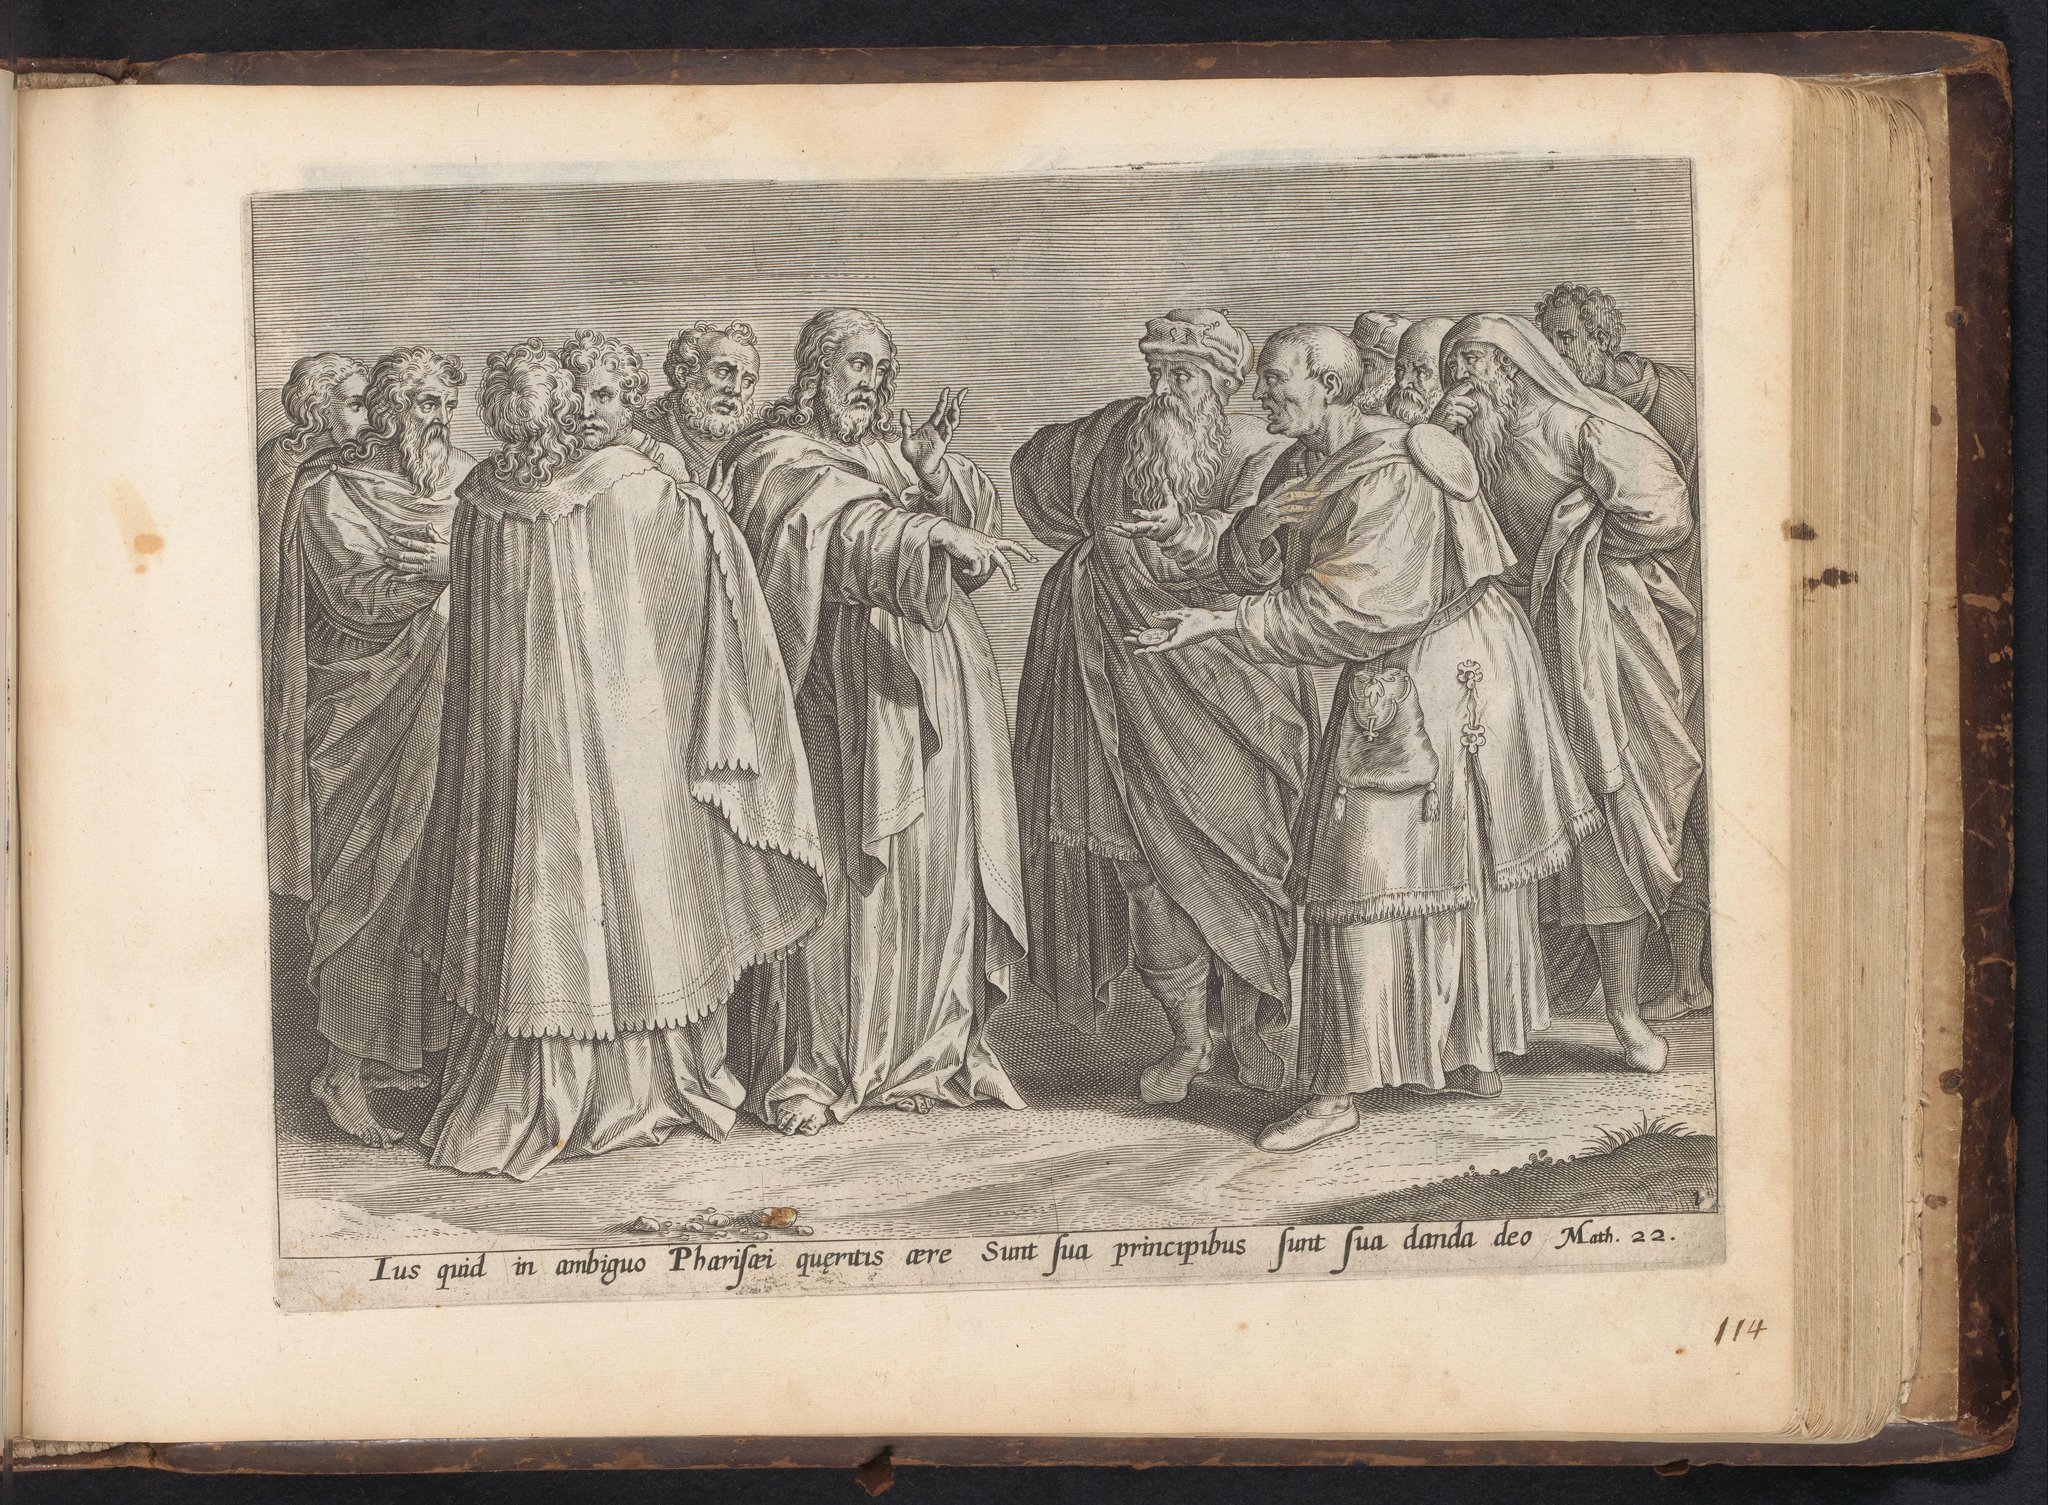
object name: print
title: Den Grooten Figuer-Bibel (...)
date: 1585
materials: paper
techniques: engraving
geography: alkmaar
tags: christ (in the temple) in debate with pharisees about the tribute to caesar (matthew 22:15-22; mark 12:13-17; luke 20:20-26)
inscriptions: number: ‘114’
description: Christus in debat met de farizeeën. Achter hem staan zijn leerlingen. Een van de farizeeën toont hem een munt en vraagt aan Christus of het toegestaan is belasting aan de keizer te betalen. Onder de voorstelling een verwijzing in het Latijn naar de Bijbeltekst in Mat. 22. Deze prent maakt deel uit van een album.